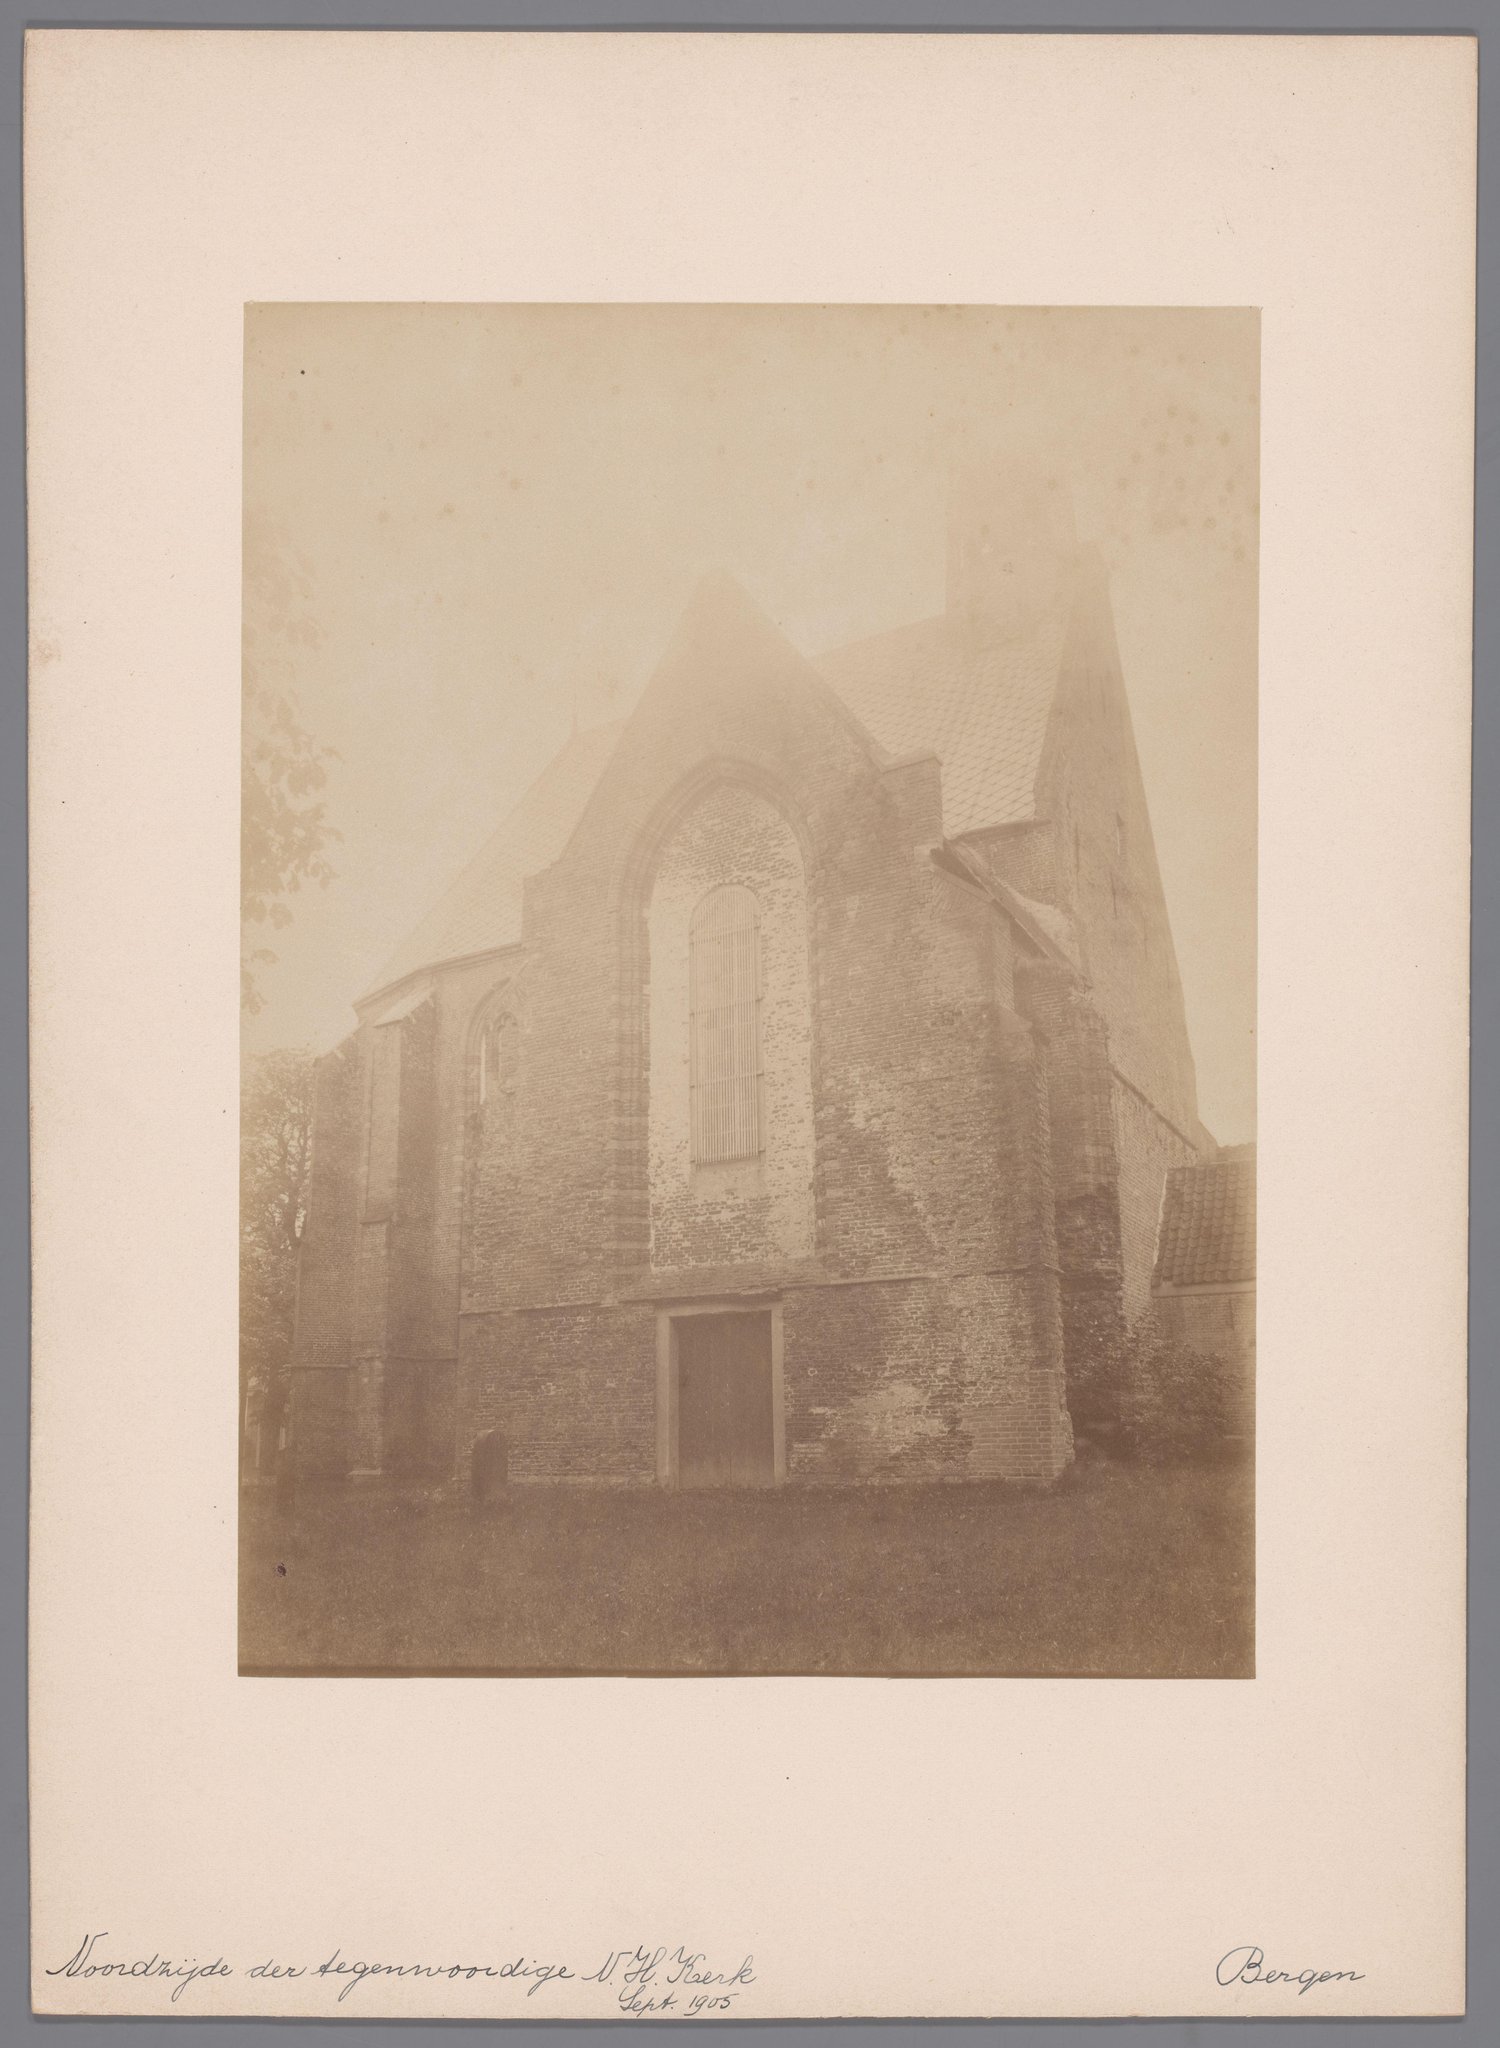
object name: photograph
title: Ruïnekerk te Bergen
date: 1905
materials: cardboard, photographic support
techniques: albumen print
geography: bergen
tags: church (exterior), ruin of church, monastery, etc.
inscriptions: annotation: ‘Noordzijde der tegenwoordige N.H. Kerk/ Sept. 1905/ Bergen’, annotation: ‘Bergen N.H./ Noordzijde van de tegenwoordige kerk/ sept 1905’